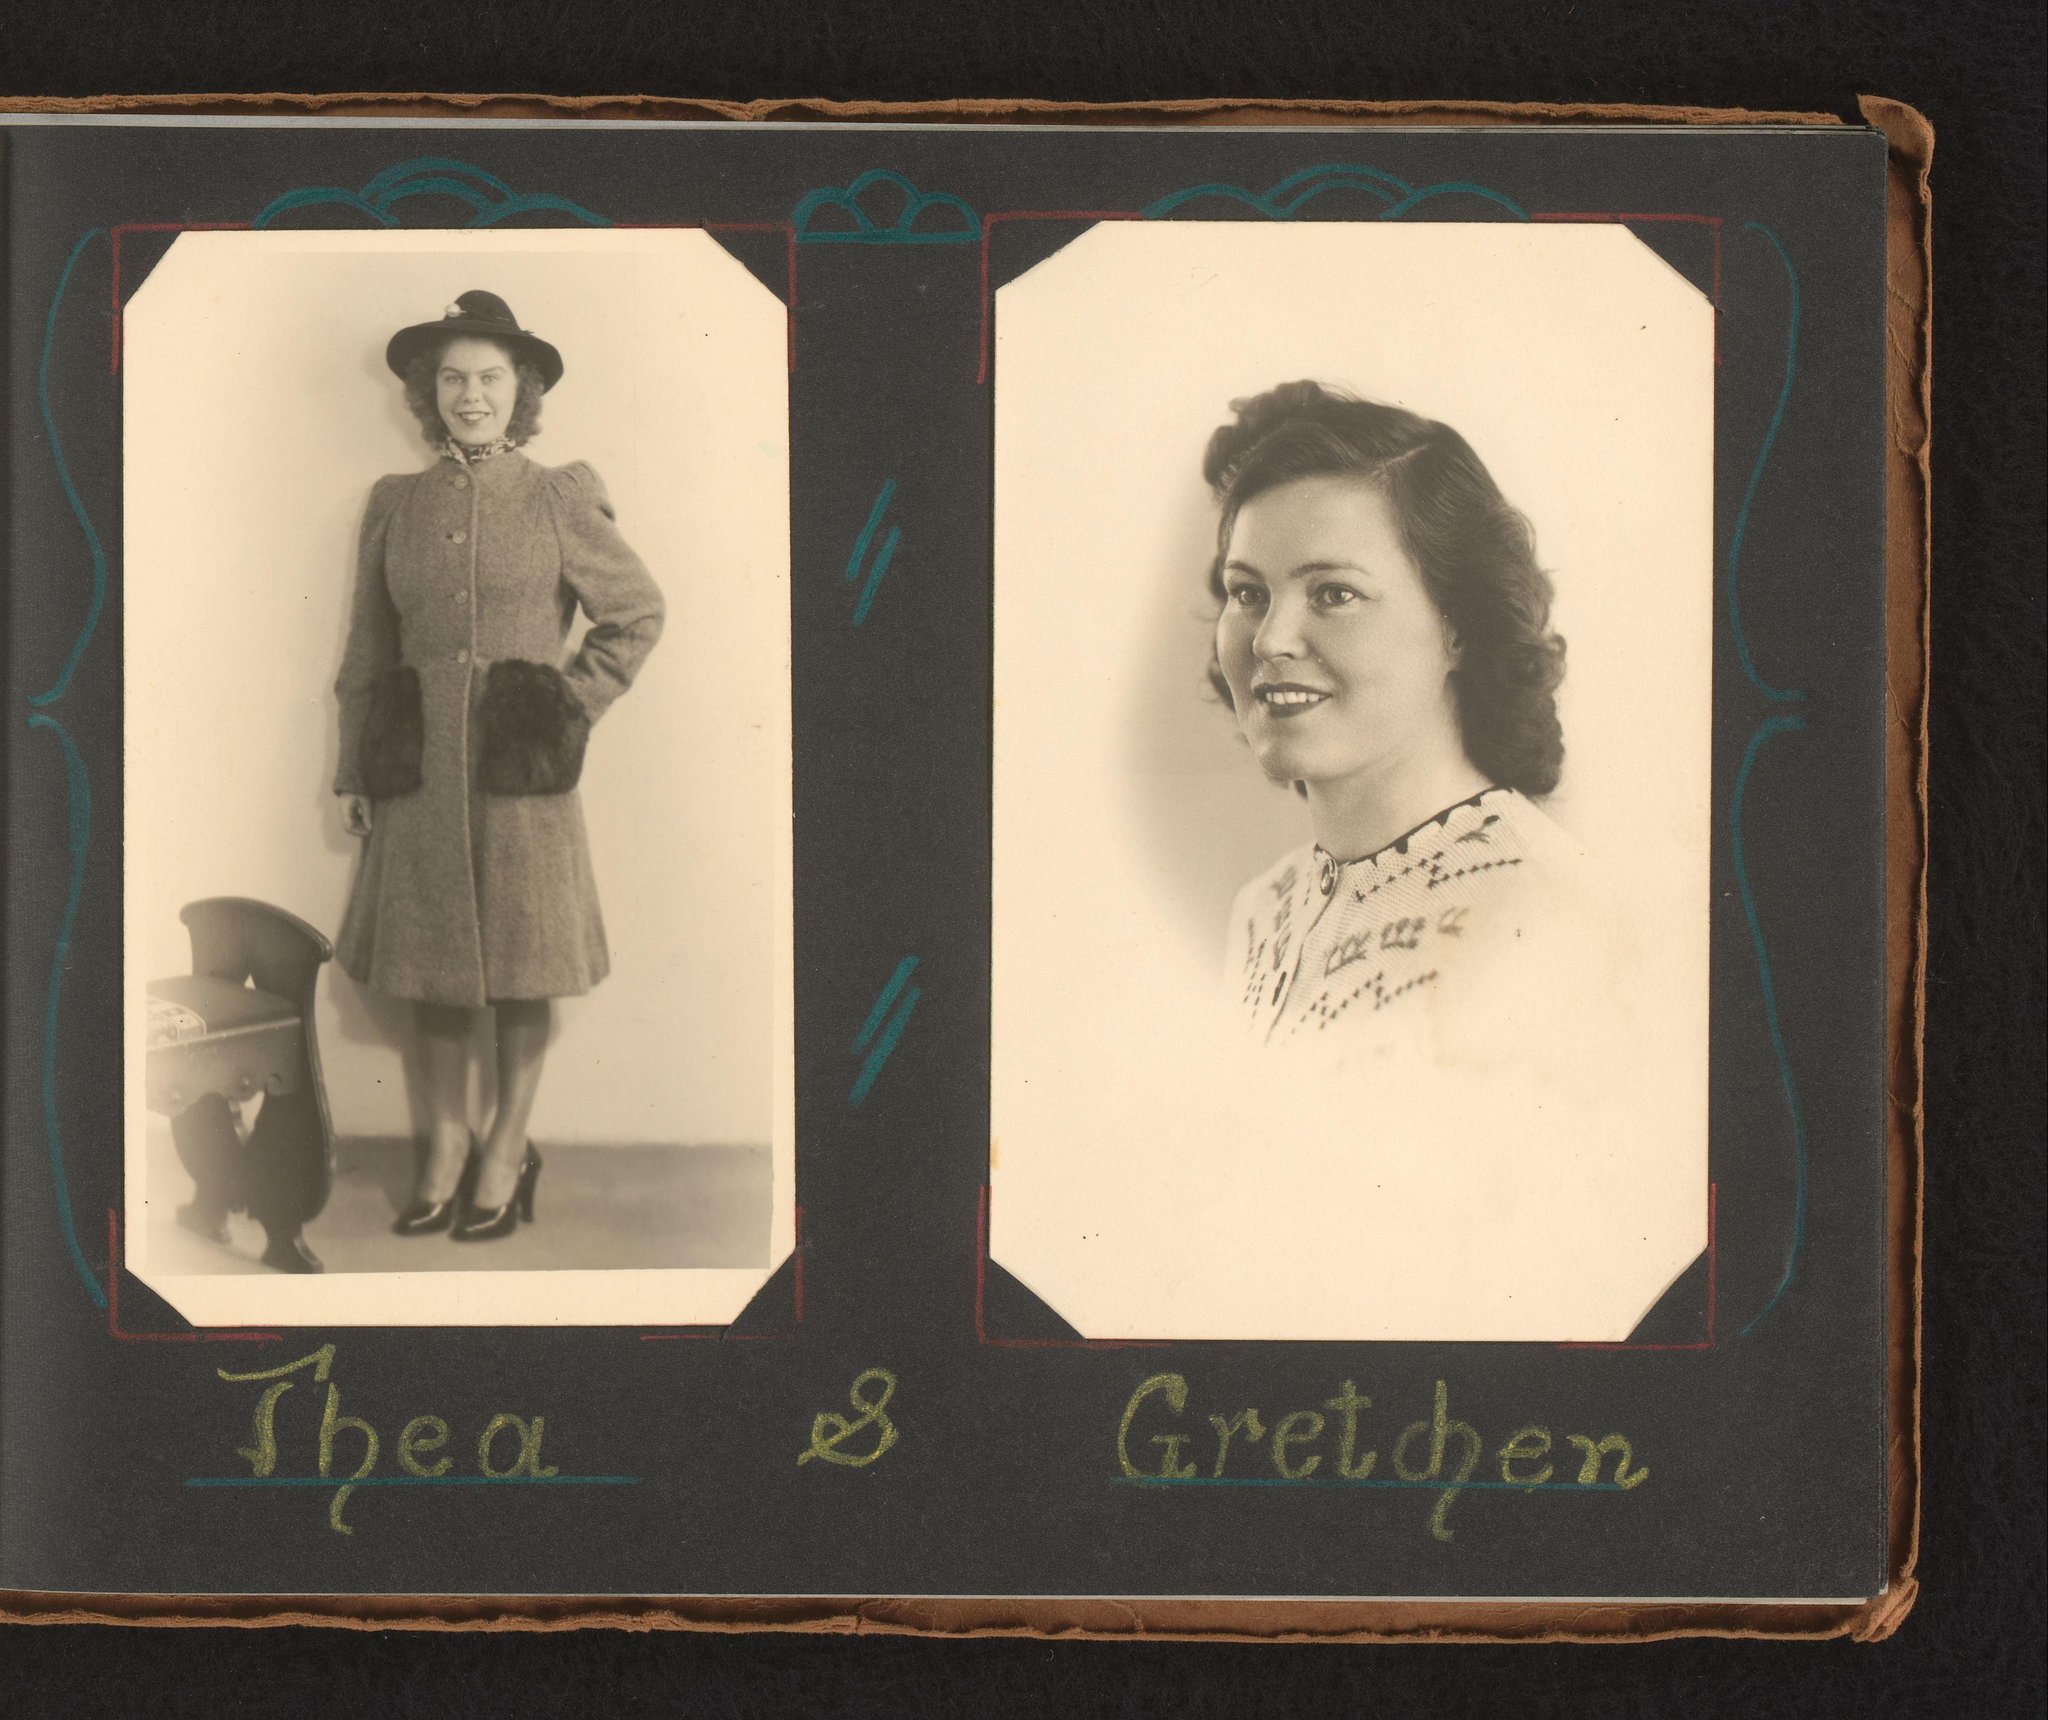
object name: photograph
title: Thea & Gretchen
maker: Anonymous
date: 1943-1944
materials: paper, pencil, photographic support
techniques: gelatin silver print, writing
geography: netherlands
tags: historical persons - bb - woman, netherlands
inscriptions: inscription: ‘Thea & Gretchen’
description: Albumblad met twee foto's van 'Vriendinnetjes uit Nederland': Thea Driesen en Gretchen. Onderdeel van een fotoalbum over de Duitse Werner Neufang van de Kriegsmarine en de Nederlandse Thea Driesen.